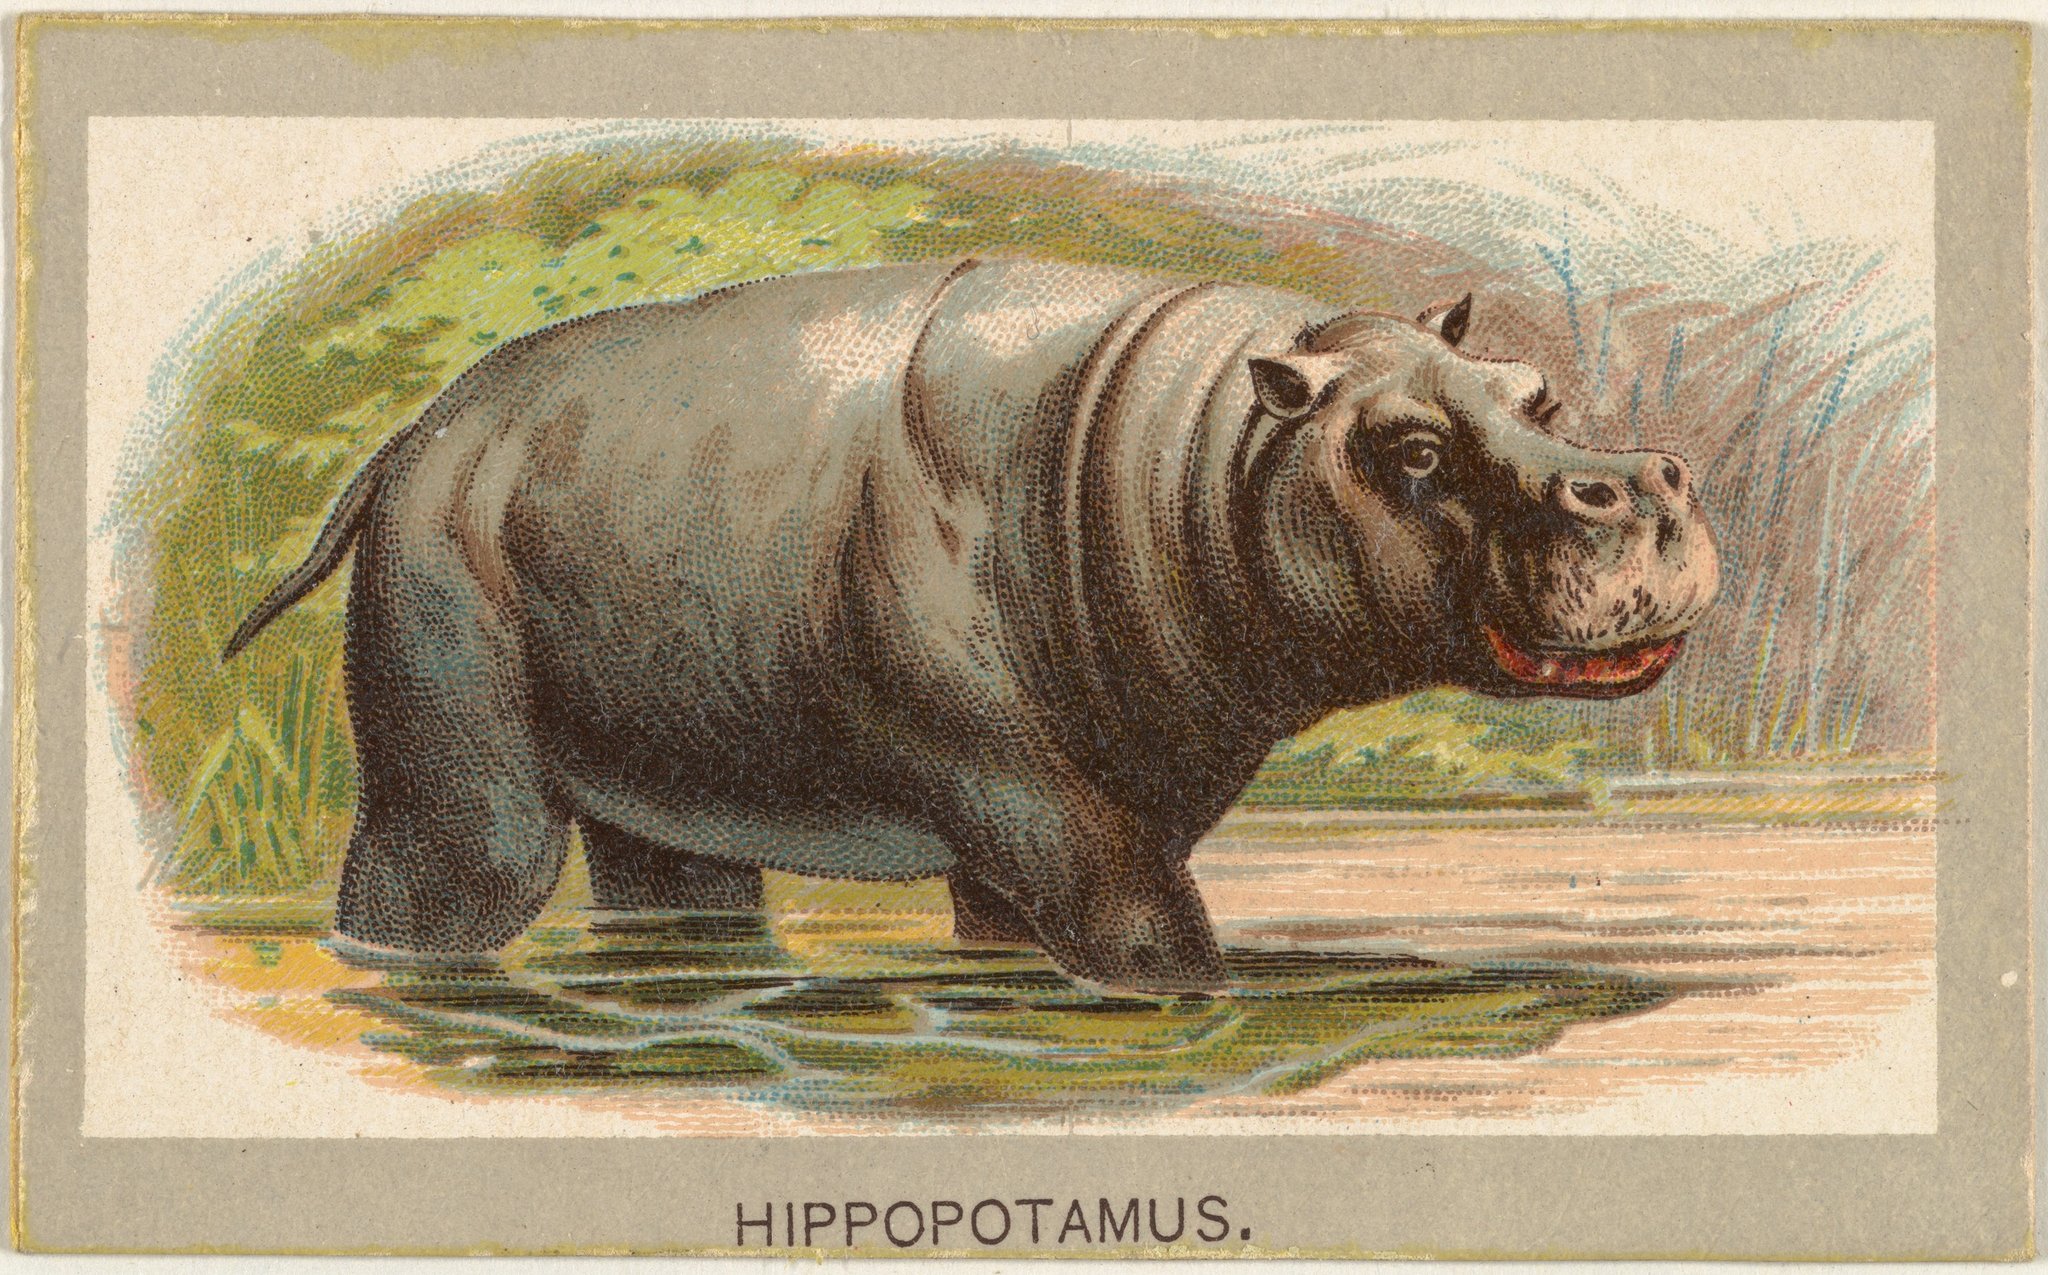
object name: print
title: Hippopotamus, from the Animals of the World series (T180), issued by Abdul Cigarettes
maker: abdul cigarettes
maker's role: publisher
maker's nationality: american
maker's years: 1881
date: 1881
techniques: color lithograph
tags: hippos